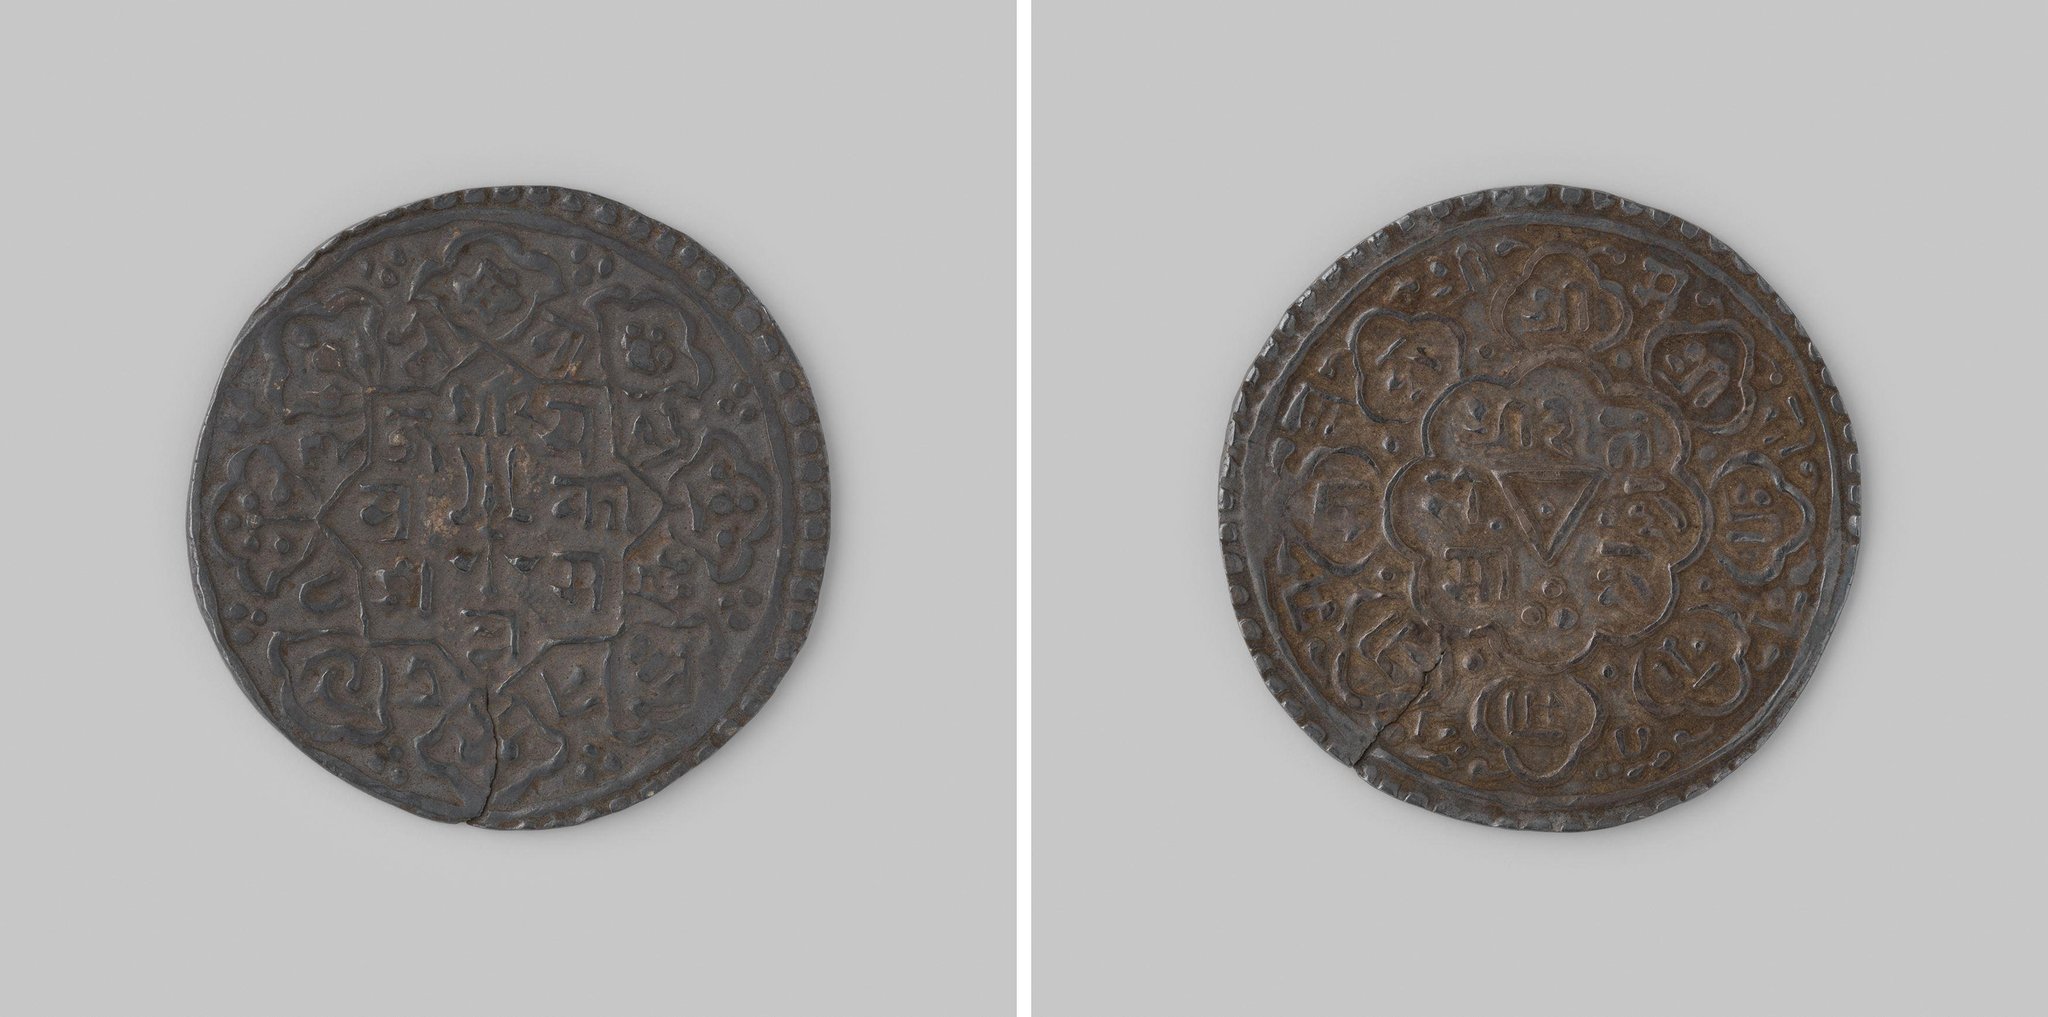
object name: coin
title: Nepal, Bhaskara Malla van Katmandu, mohar, 823 [= 1702]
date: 1702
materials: silver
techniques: striking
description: Zilveren munt. Voorzijde: binnen een cirkel een trisul, waaromheen zeven tekens in Nagari-schrift met de betekenis: sri sri jaya Bhaskara. Rondom de cirkel een rand met ornamenten, waarin acht afgescheiden ruimtes met Boeddhistische symbolen. Keerzijde: binnen een cirkel een stupa, waaromheen op twee regels vier tekens in Nagari-schrift met de betekenis: malla deva. In de afsnede jaartal in Nepalese cijfers: 823. Rondom de cirkel een rand met ornamenten, waarin acht afgescheiden ruimtes, met in elke ruimte een teken in Nagari-schrift met de betekenis: nepale/svara girindra. Gladde rand.